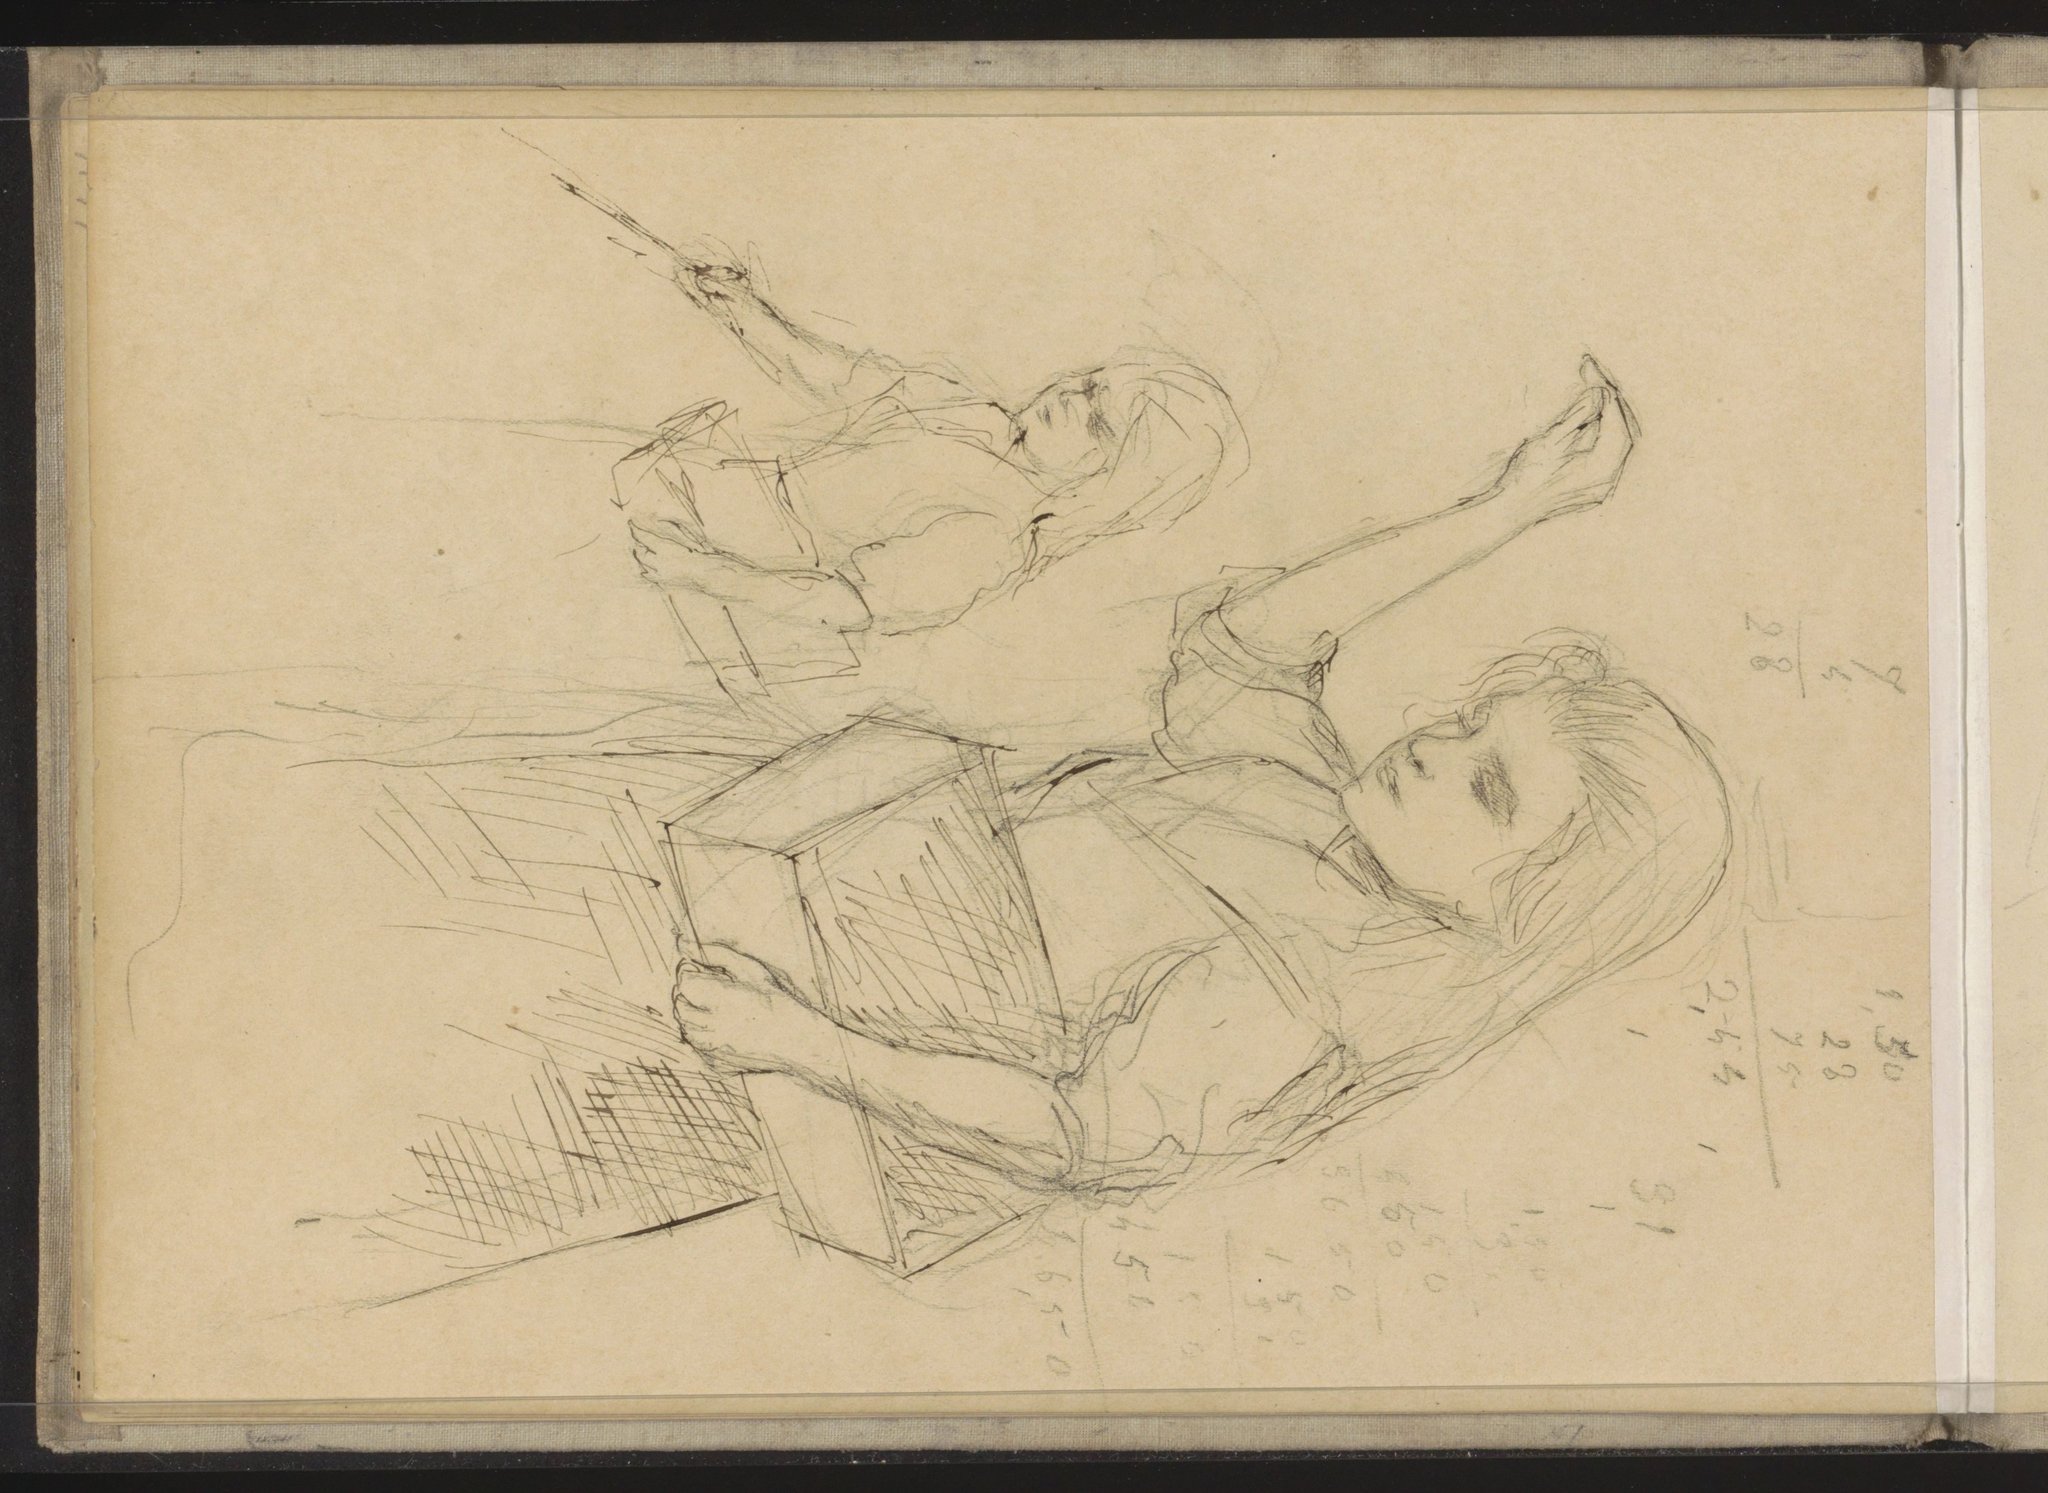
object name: sketchbook leaf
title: Meisje met een doos onder haar arm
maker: jozef israëls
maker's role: draughtsman, painter, print maker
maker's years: 1824-1911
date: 1834-1911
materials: ink, paper, pencil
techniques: pen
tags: container of paper, cardboard: bag, carton, girl (child between toddler and youth)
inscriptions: annotation: ‘[...]’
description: Het meisje is zowel met een opgeheven arm getekend als met een stok in haar hand. Blad 17 verso uit een schetsboek met 18 bladen.